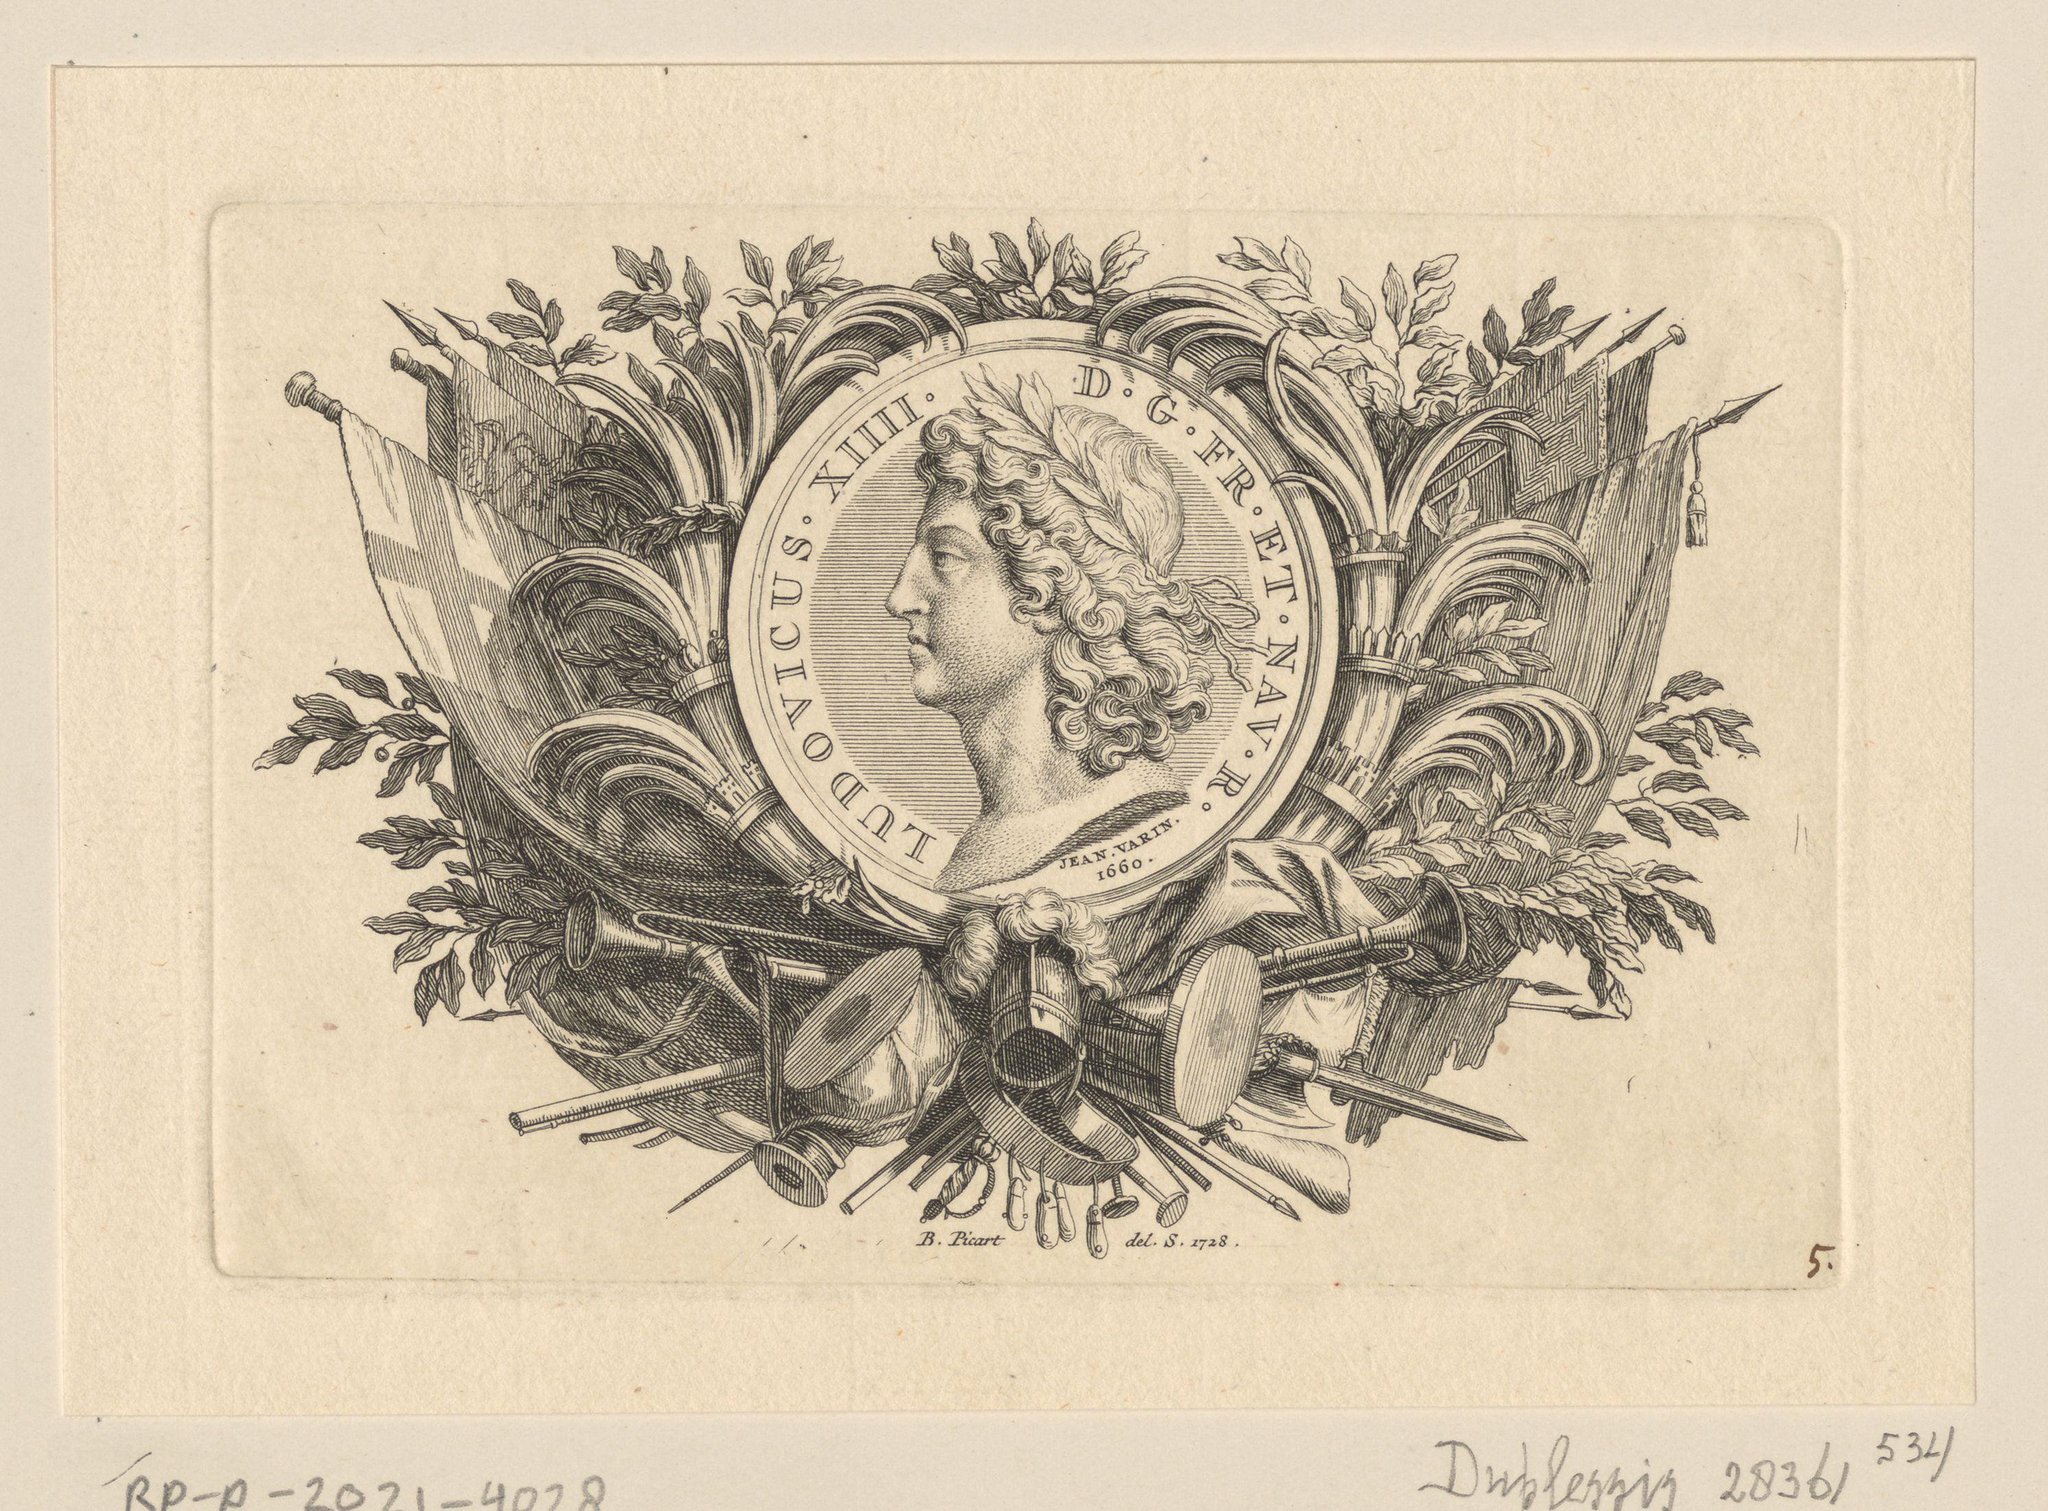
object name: book illustration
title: Penning met portret van Lodewijk XIV van Frankrijk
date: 1728-1729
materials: paper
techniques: etching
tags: lodewijk xiv (koning van frankrijk), historical persons, medal (considered as a piece of sculpture, regardless of its specific function), king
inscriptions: number: ‘5’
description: Prent met tekst in boekdruk gebruikt in: Boileau-Despréaux, Nicolas. Oeuvres. Den Haag: Pierre de Hondt, 1729, dl. 1.